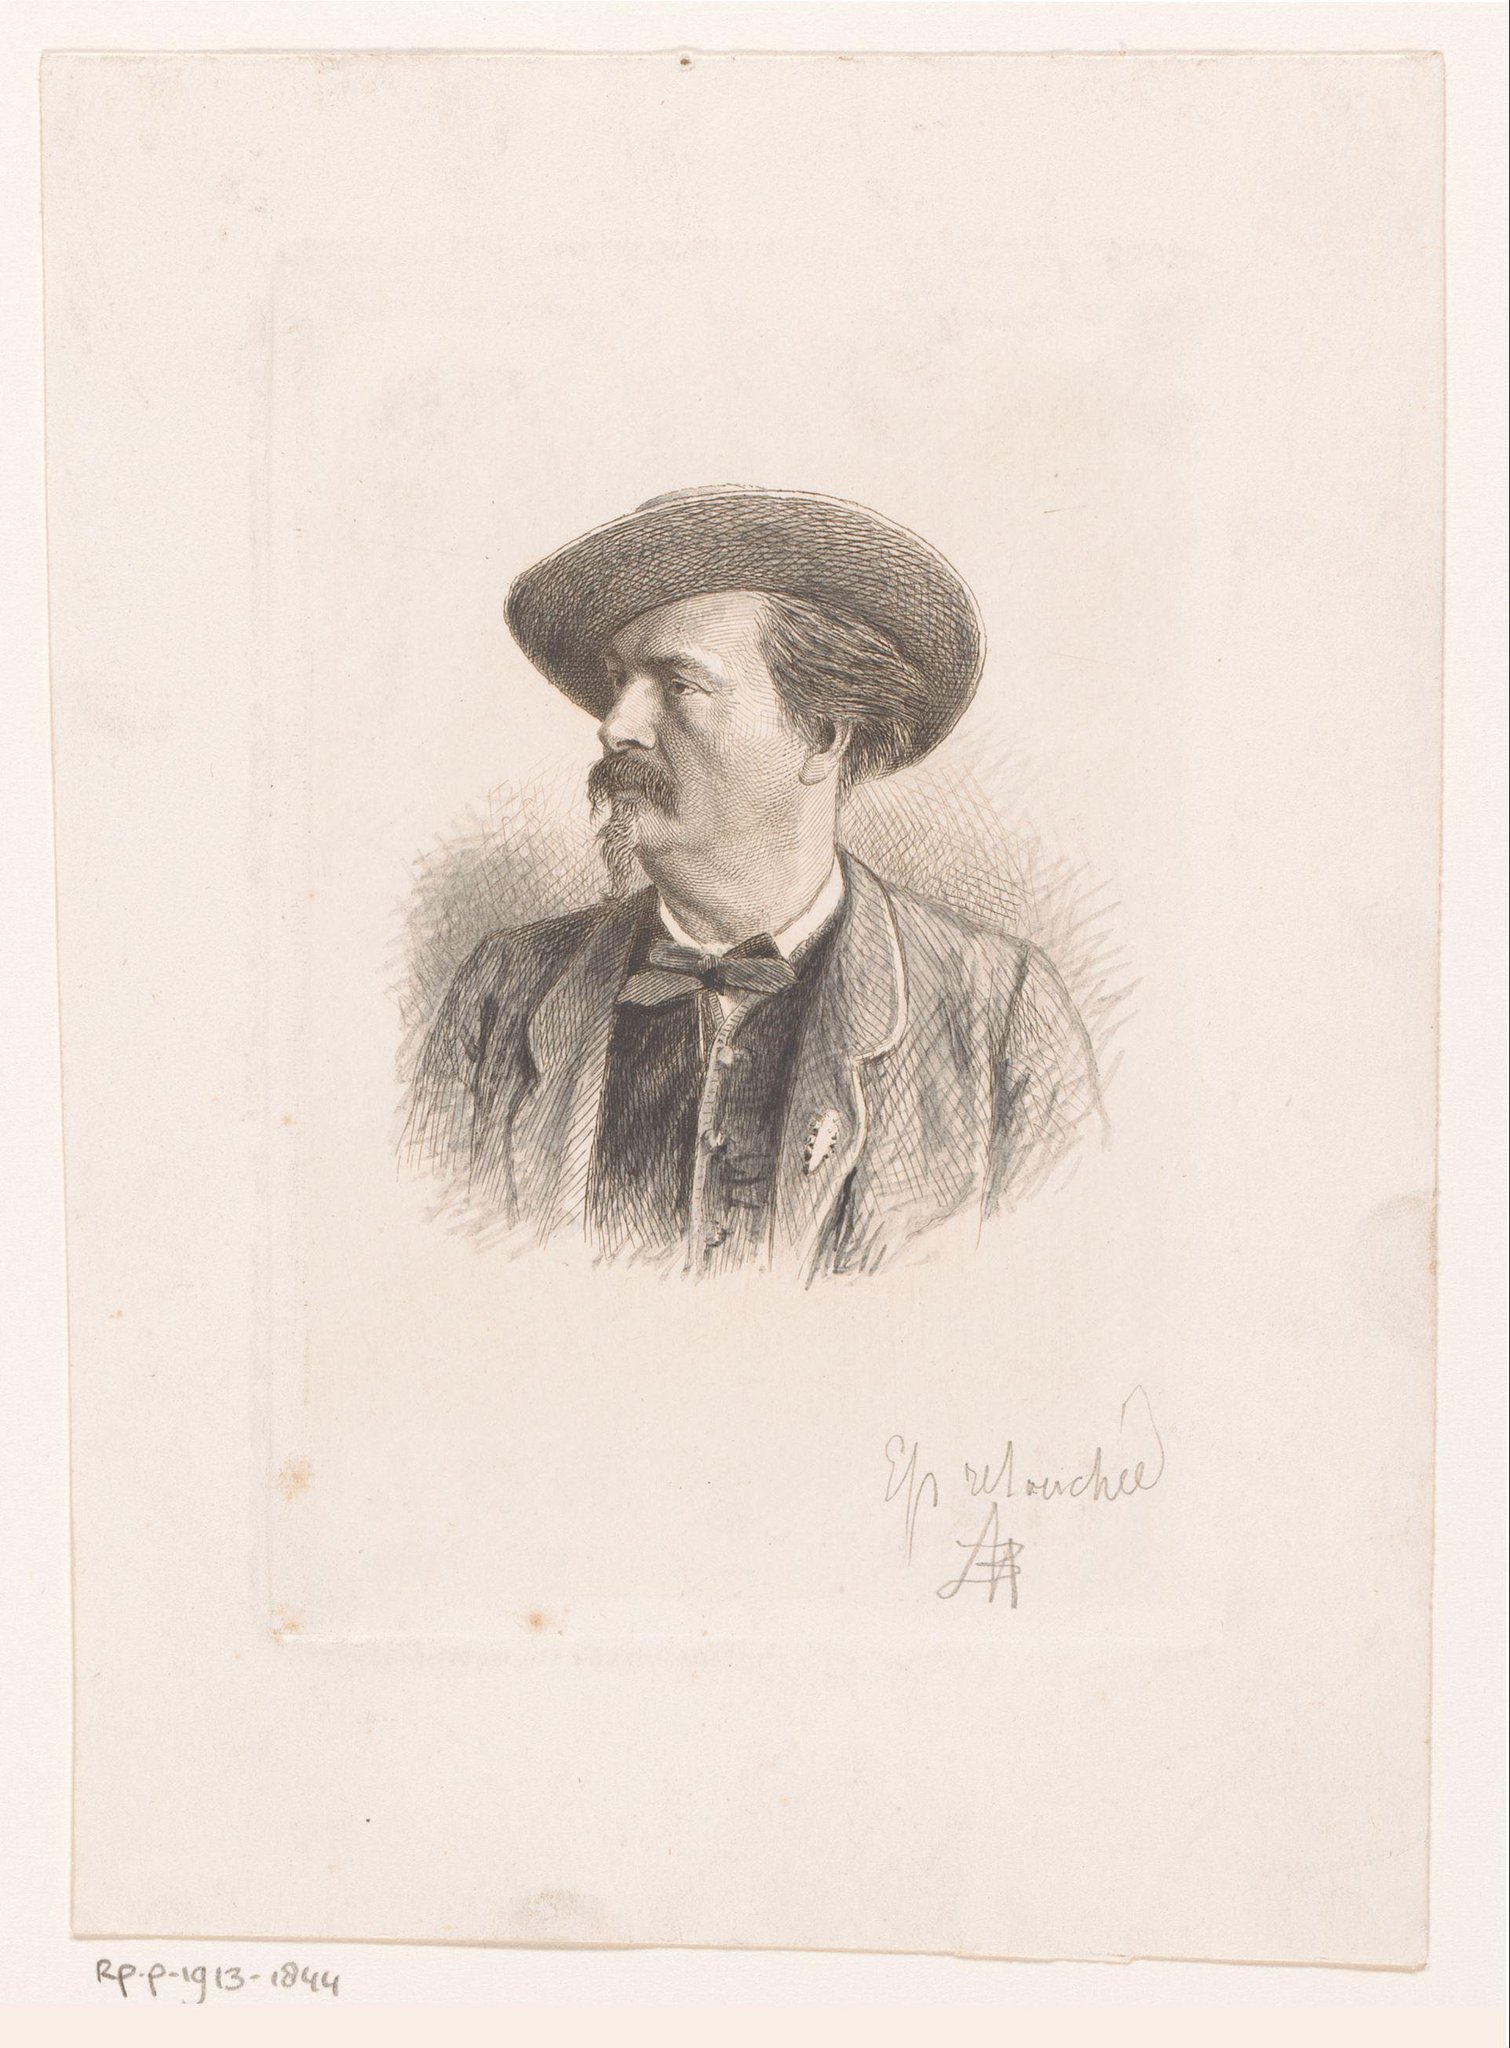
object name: print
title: Portret van een onbekende man met hoed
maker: jean baptiste pierre michiels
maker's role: print maker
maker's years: 1821-1890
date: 1831-1890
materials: ink, paper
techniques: etching, pen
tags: head-gear, adult man, historical persons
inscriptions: inscription: ‘Ep retouchee’, collector's mark: Lugt 2228